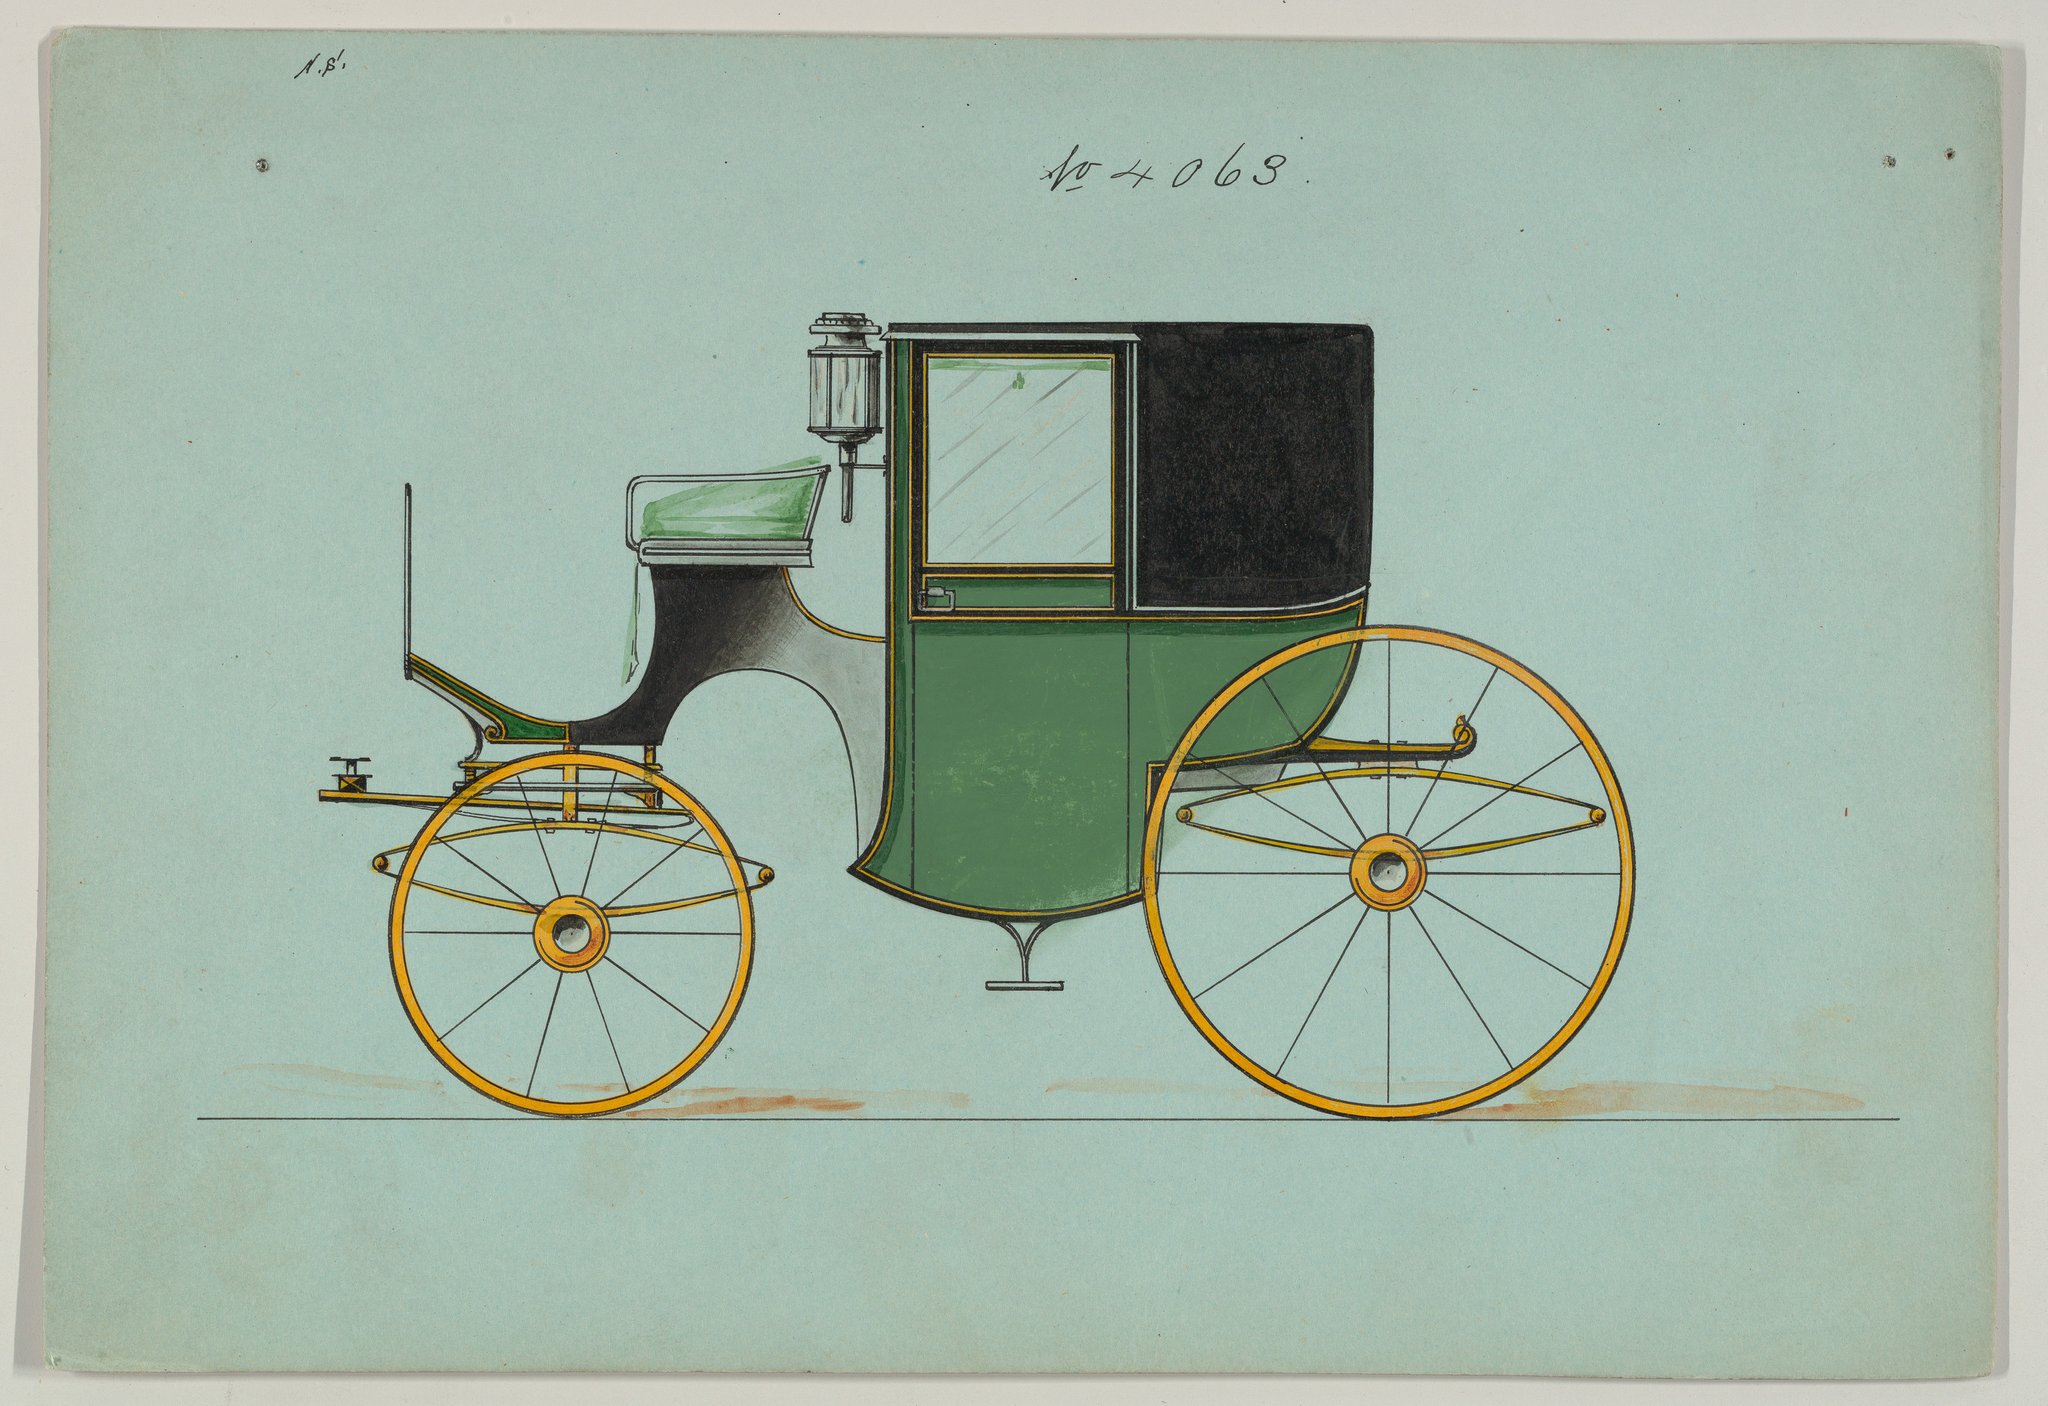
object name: drawing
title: Brougham #4063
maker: brewster & co.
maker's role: manufacturer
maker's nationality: american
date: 1890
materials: gouache, ink, watercolor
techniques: pen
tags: carriages